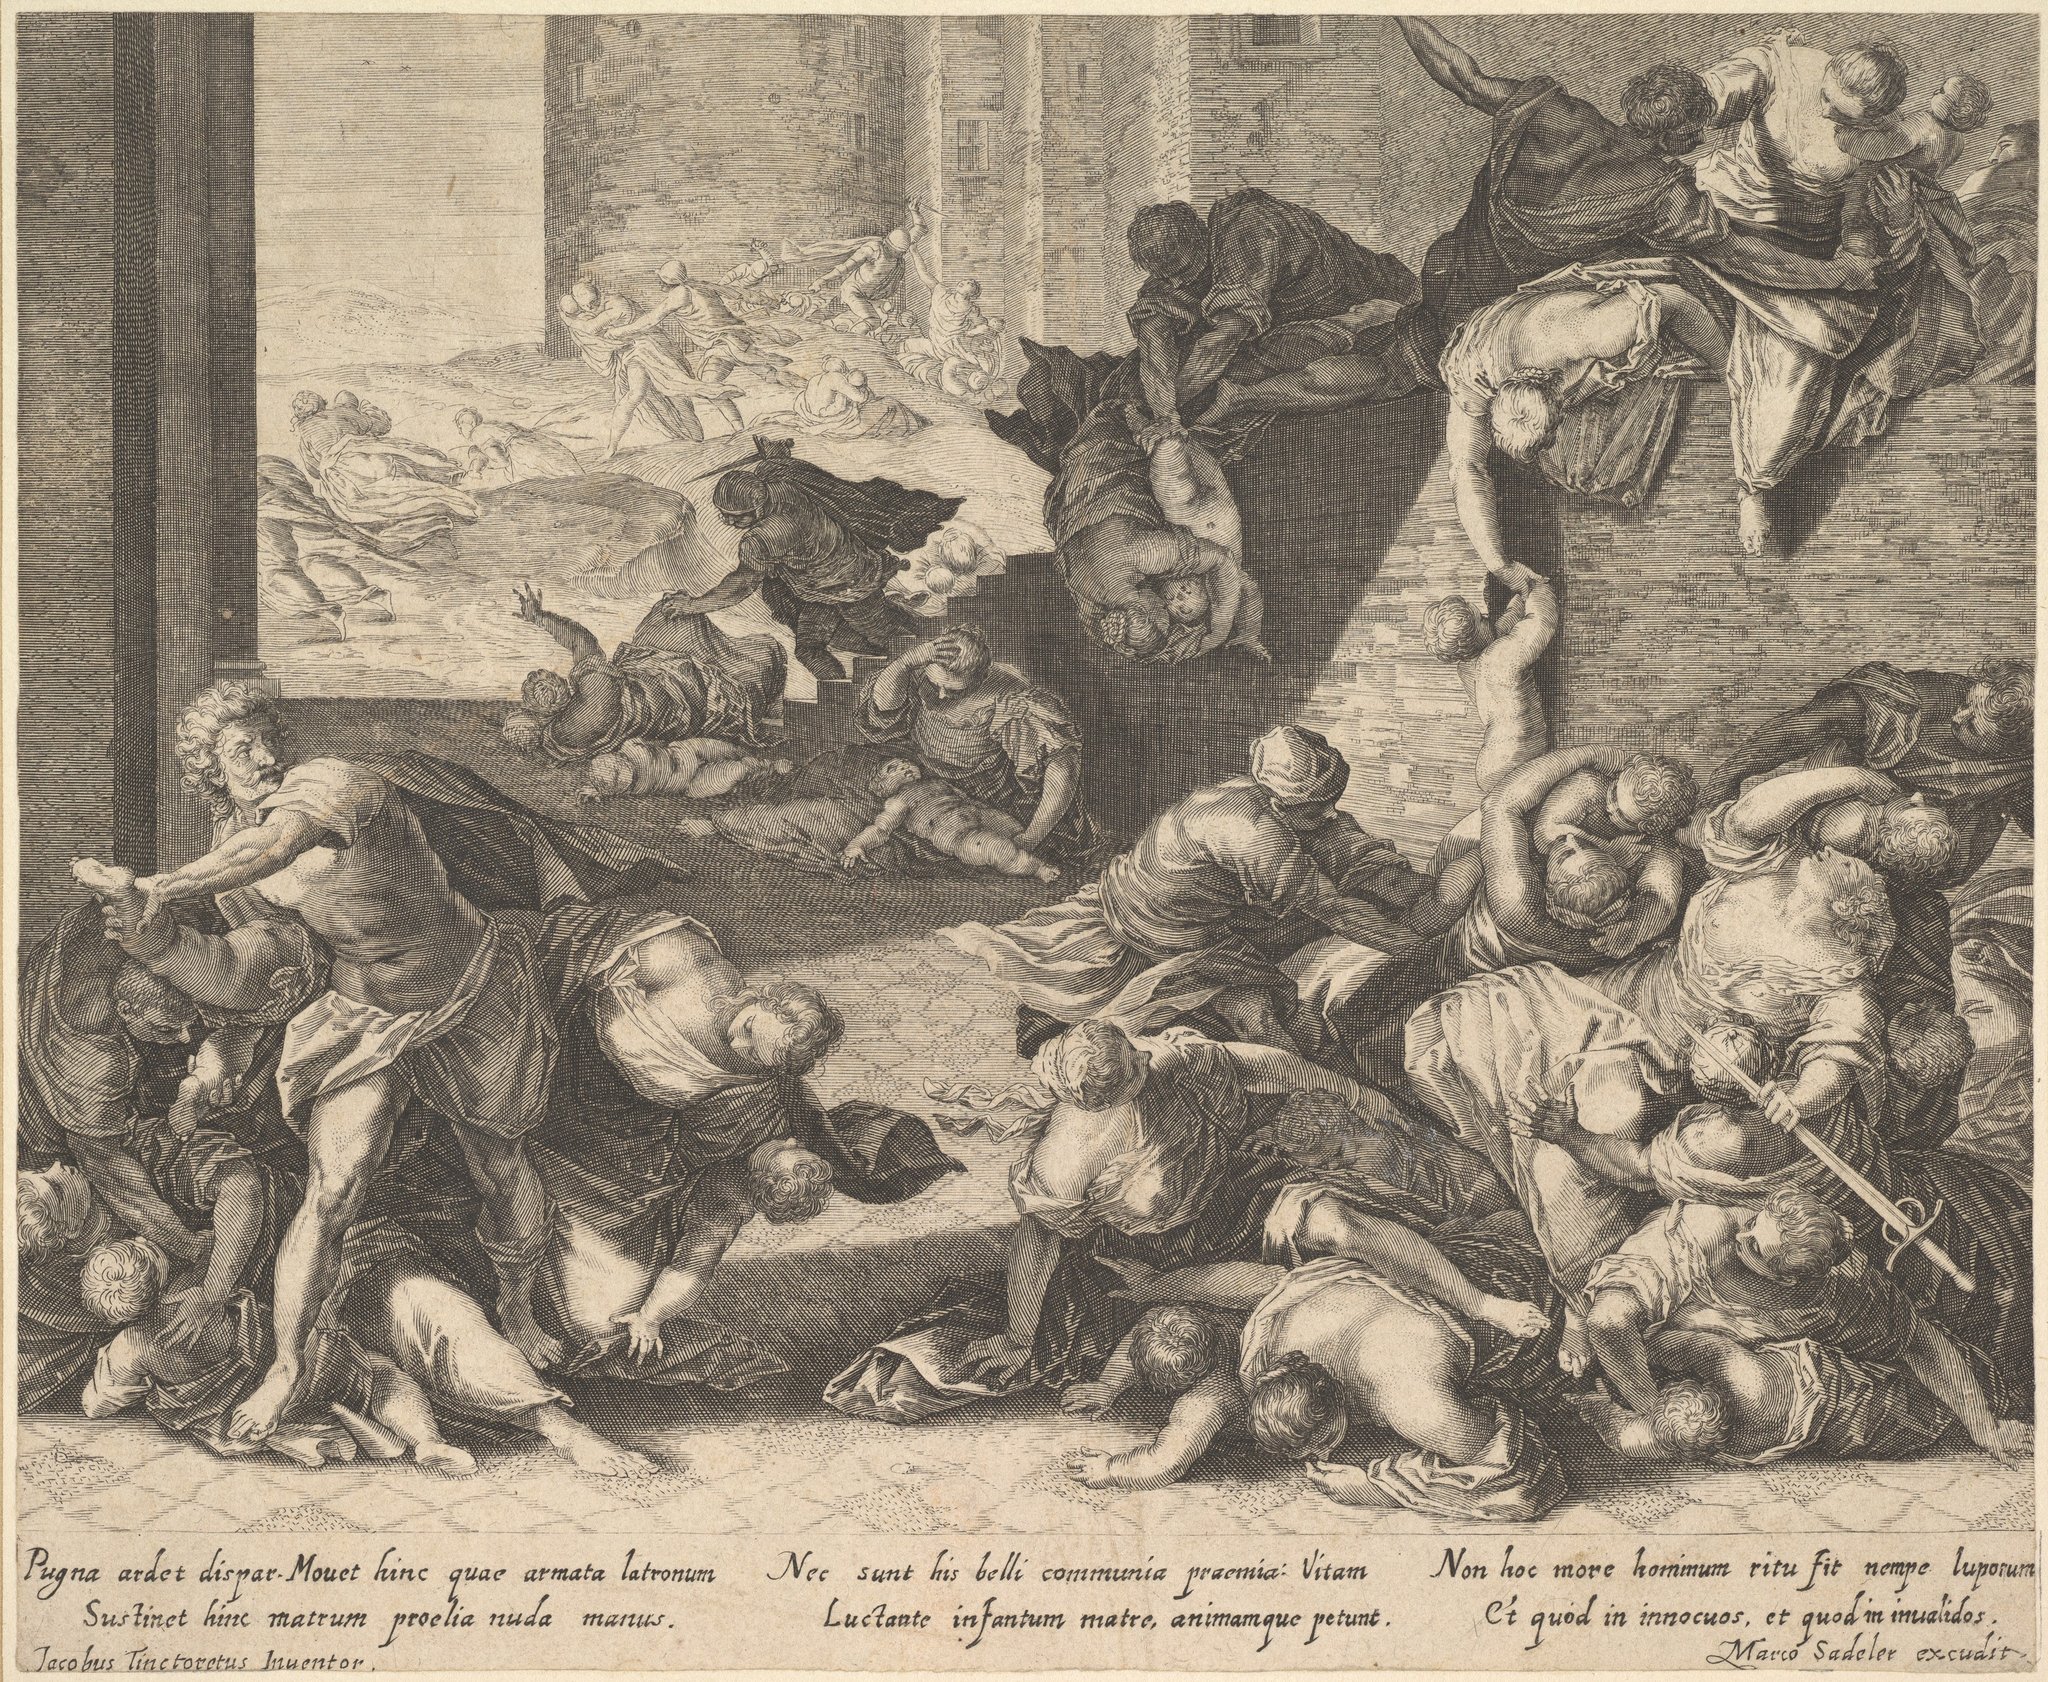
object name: print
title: Massacre of the Innocents, reduced and reversed copy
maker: Anonymous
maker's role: artist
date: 1600-1629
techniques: engraving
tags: massacres,infants,men,women